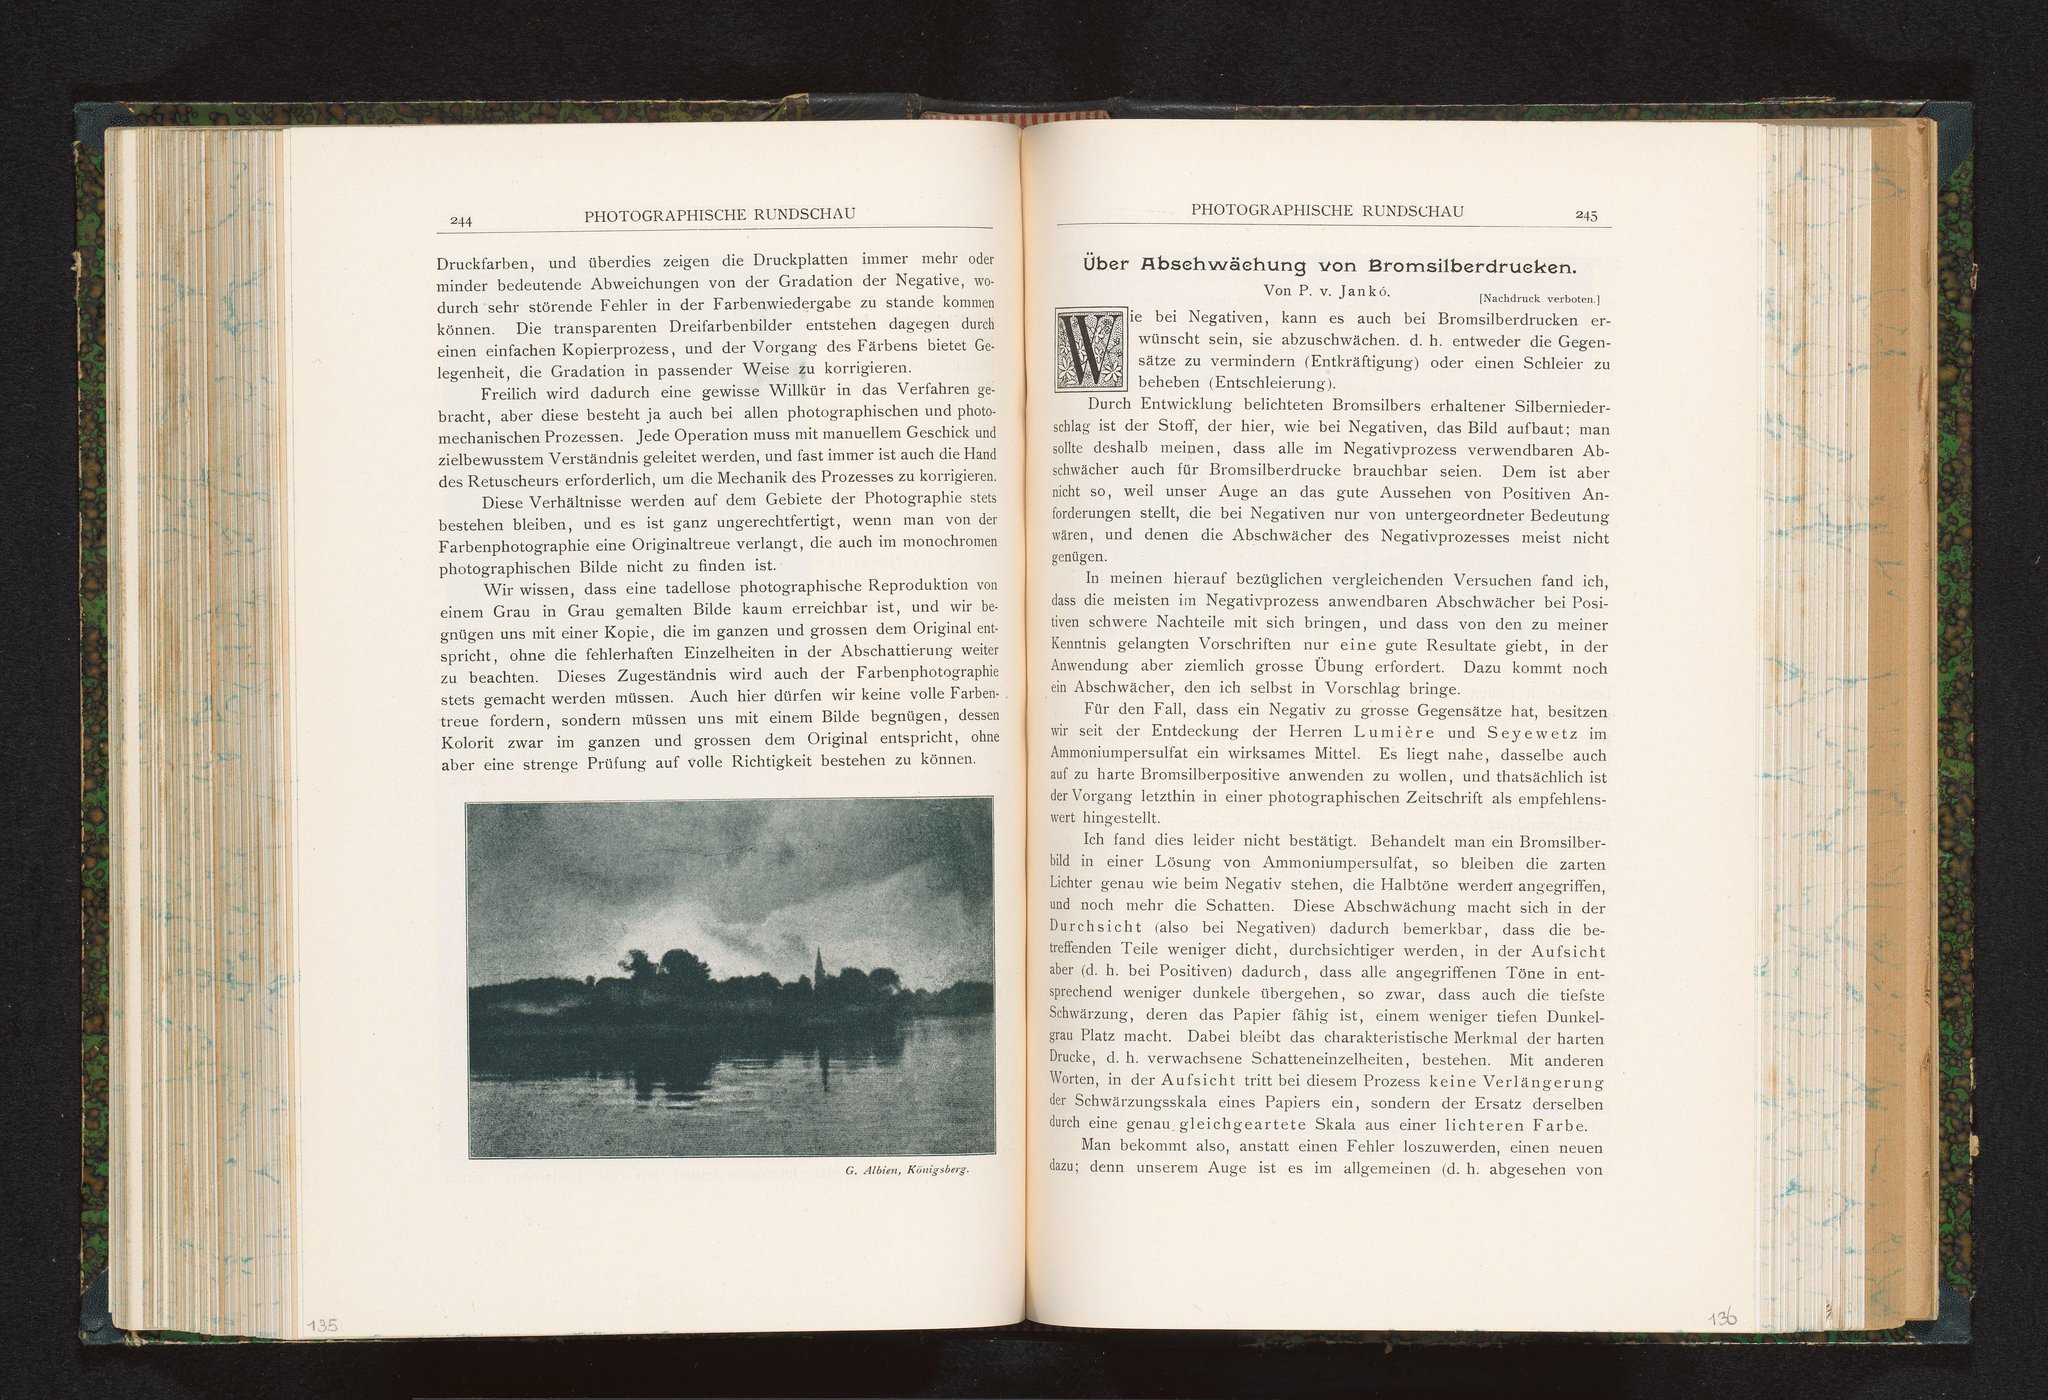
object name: page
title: Landschap met een waterpartij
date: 1894-1899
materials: paper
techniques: autotype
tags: landscapes with waters, waterscapes, seascapes (in the temperate zone)